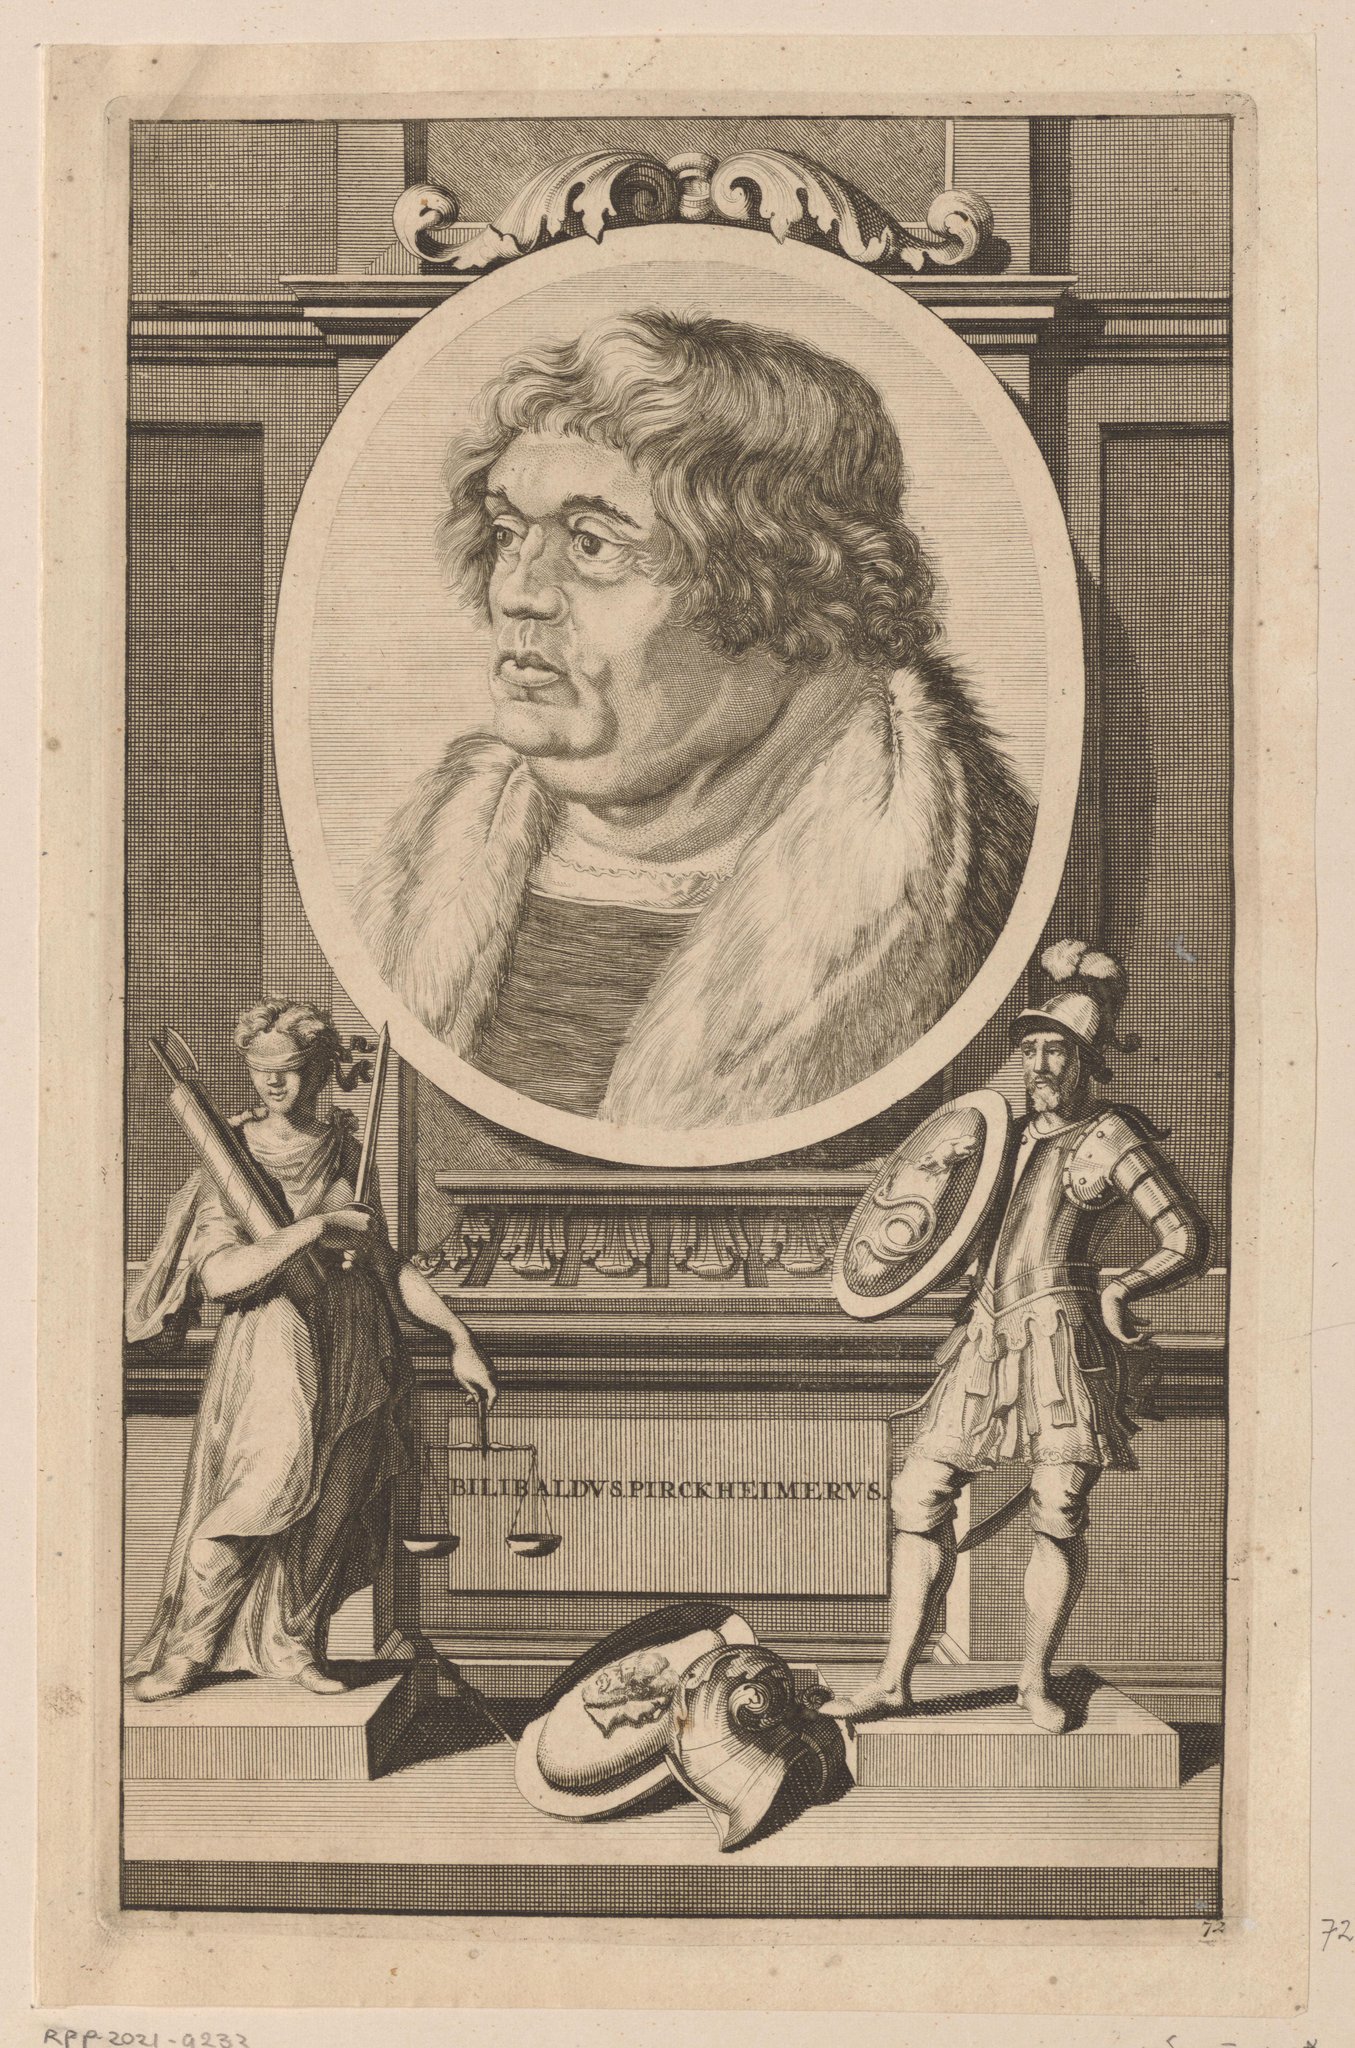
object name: print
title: Portretten van belangrijke leiders en geleerden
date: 1710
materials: paper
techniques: engraving, etching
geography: leiden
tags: eichstätt, willibald pirckheimer, adult man, historical persons, justitia (justice) as roman personification